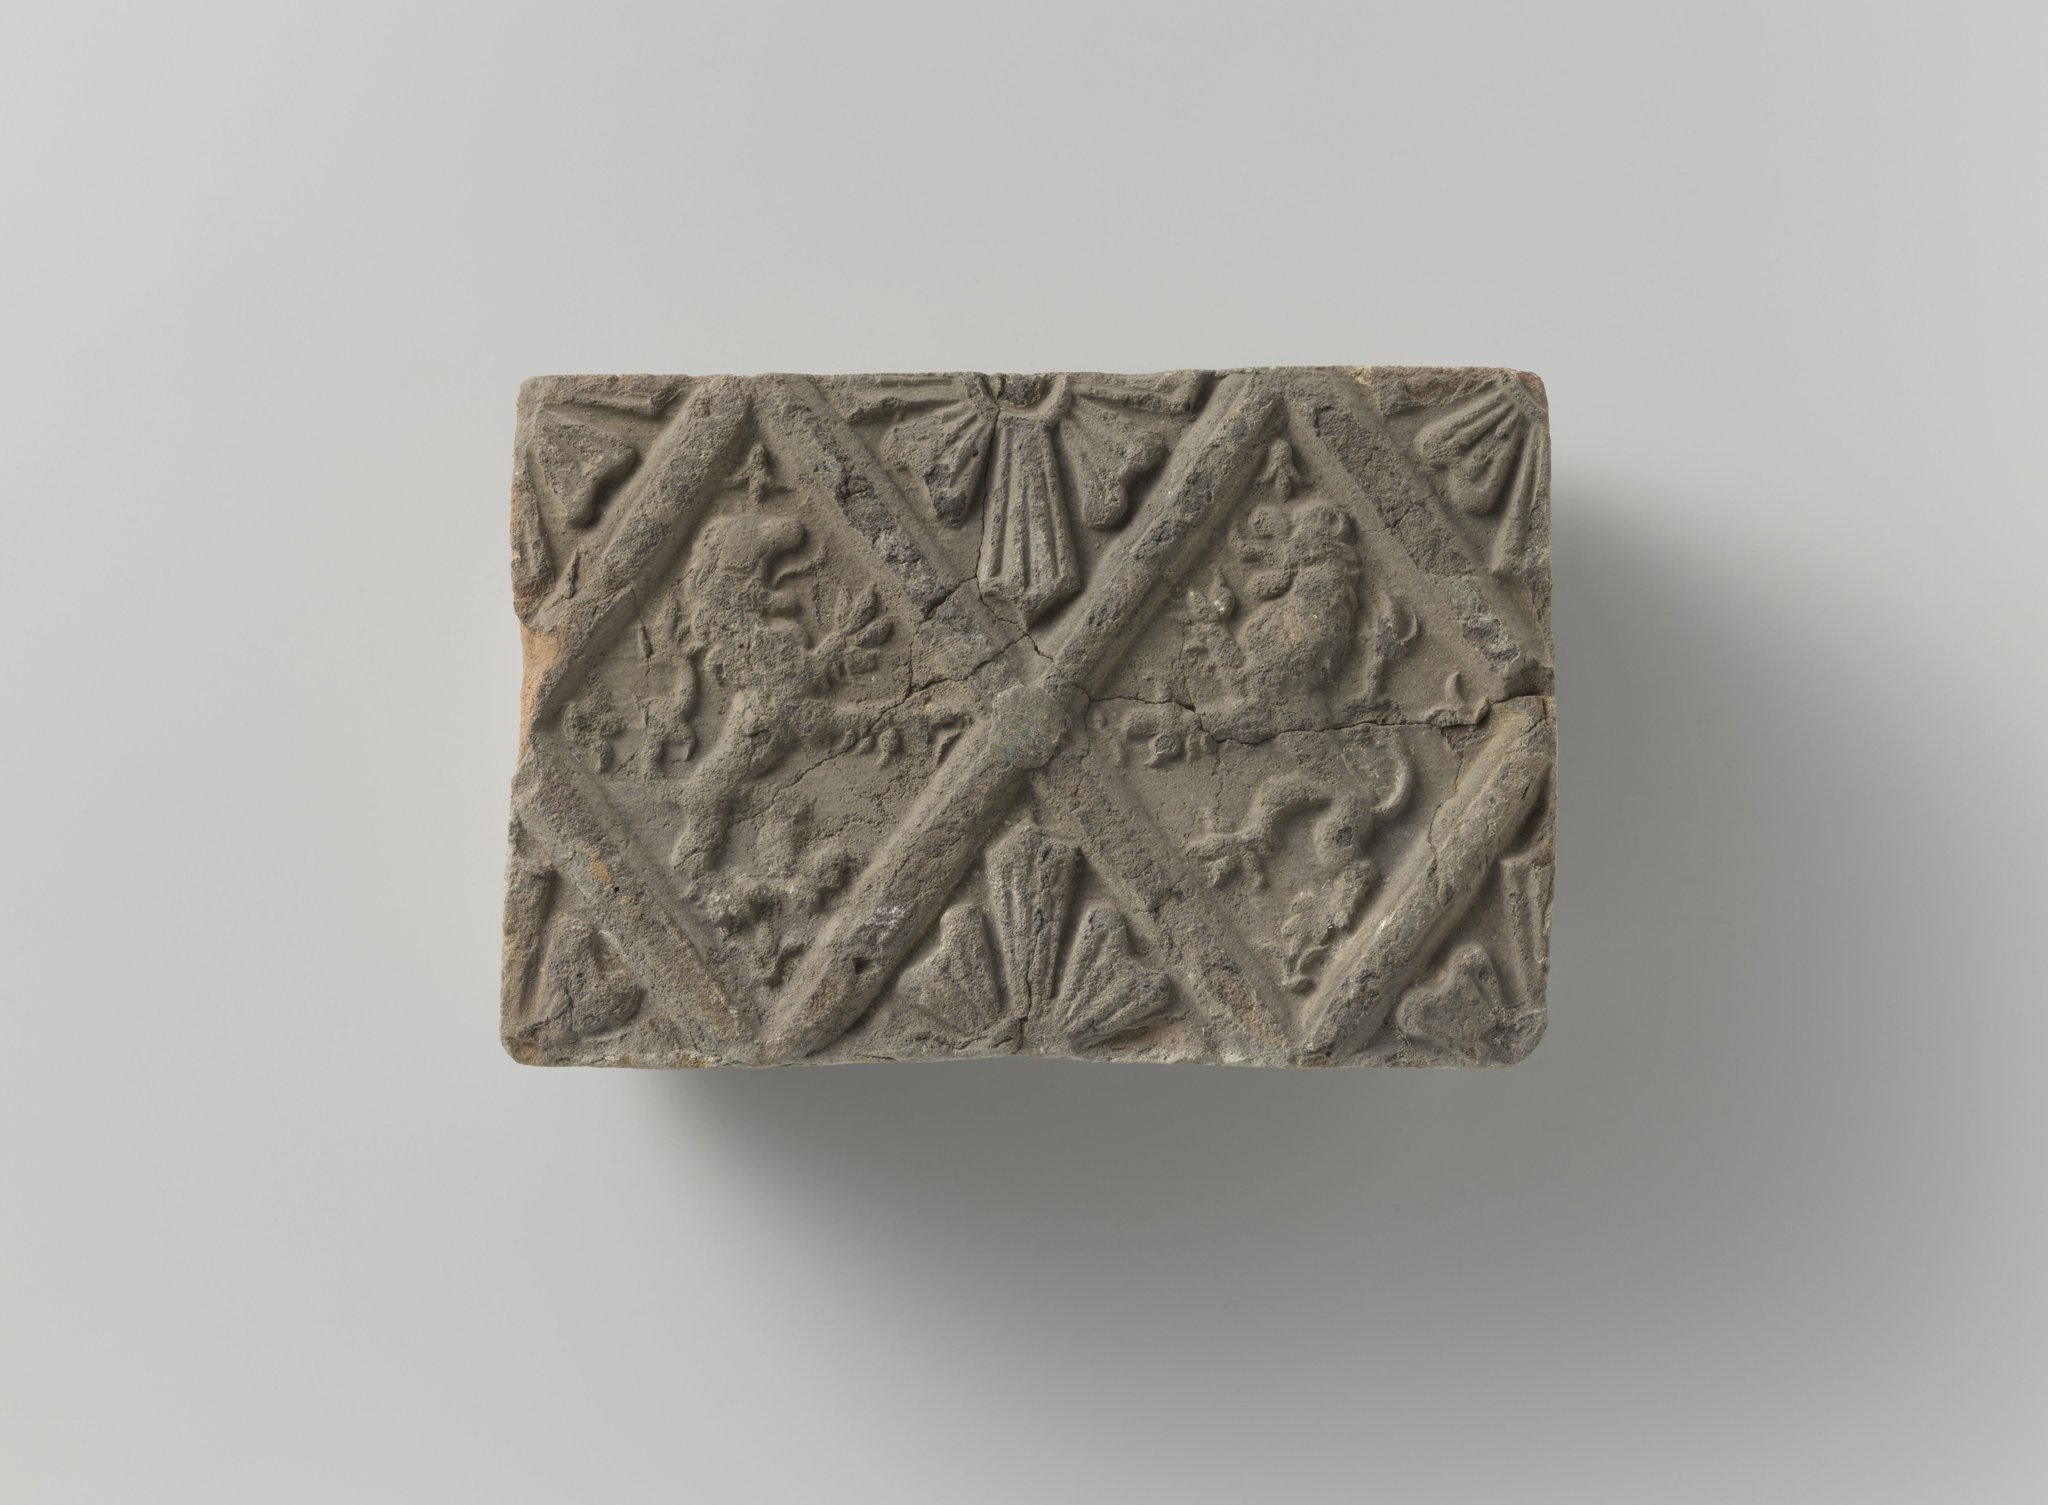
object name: hearthstone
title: Haardsteen met afbeelding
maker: Anonymous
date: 1400-1950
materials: earthenware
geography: southern netherlands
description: Haardsteen met ruiten, waarin twee heraldieke leeuwen. Oud merk 1417.